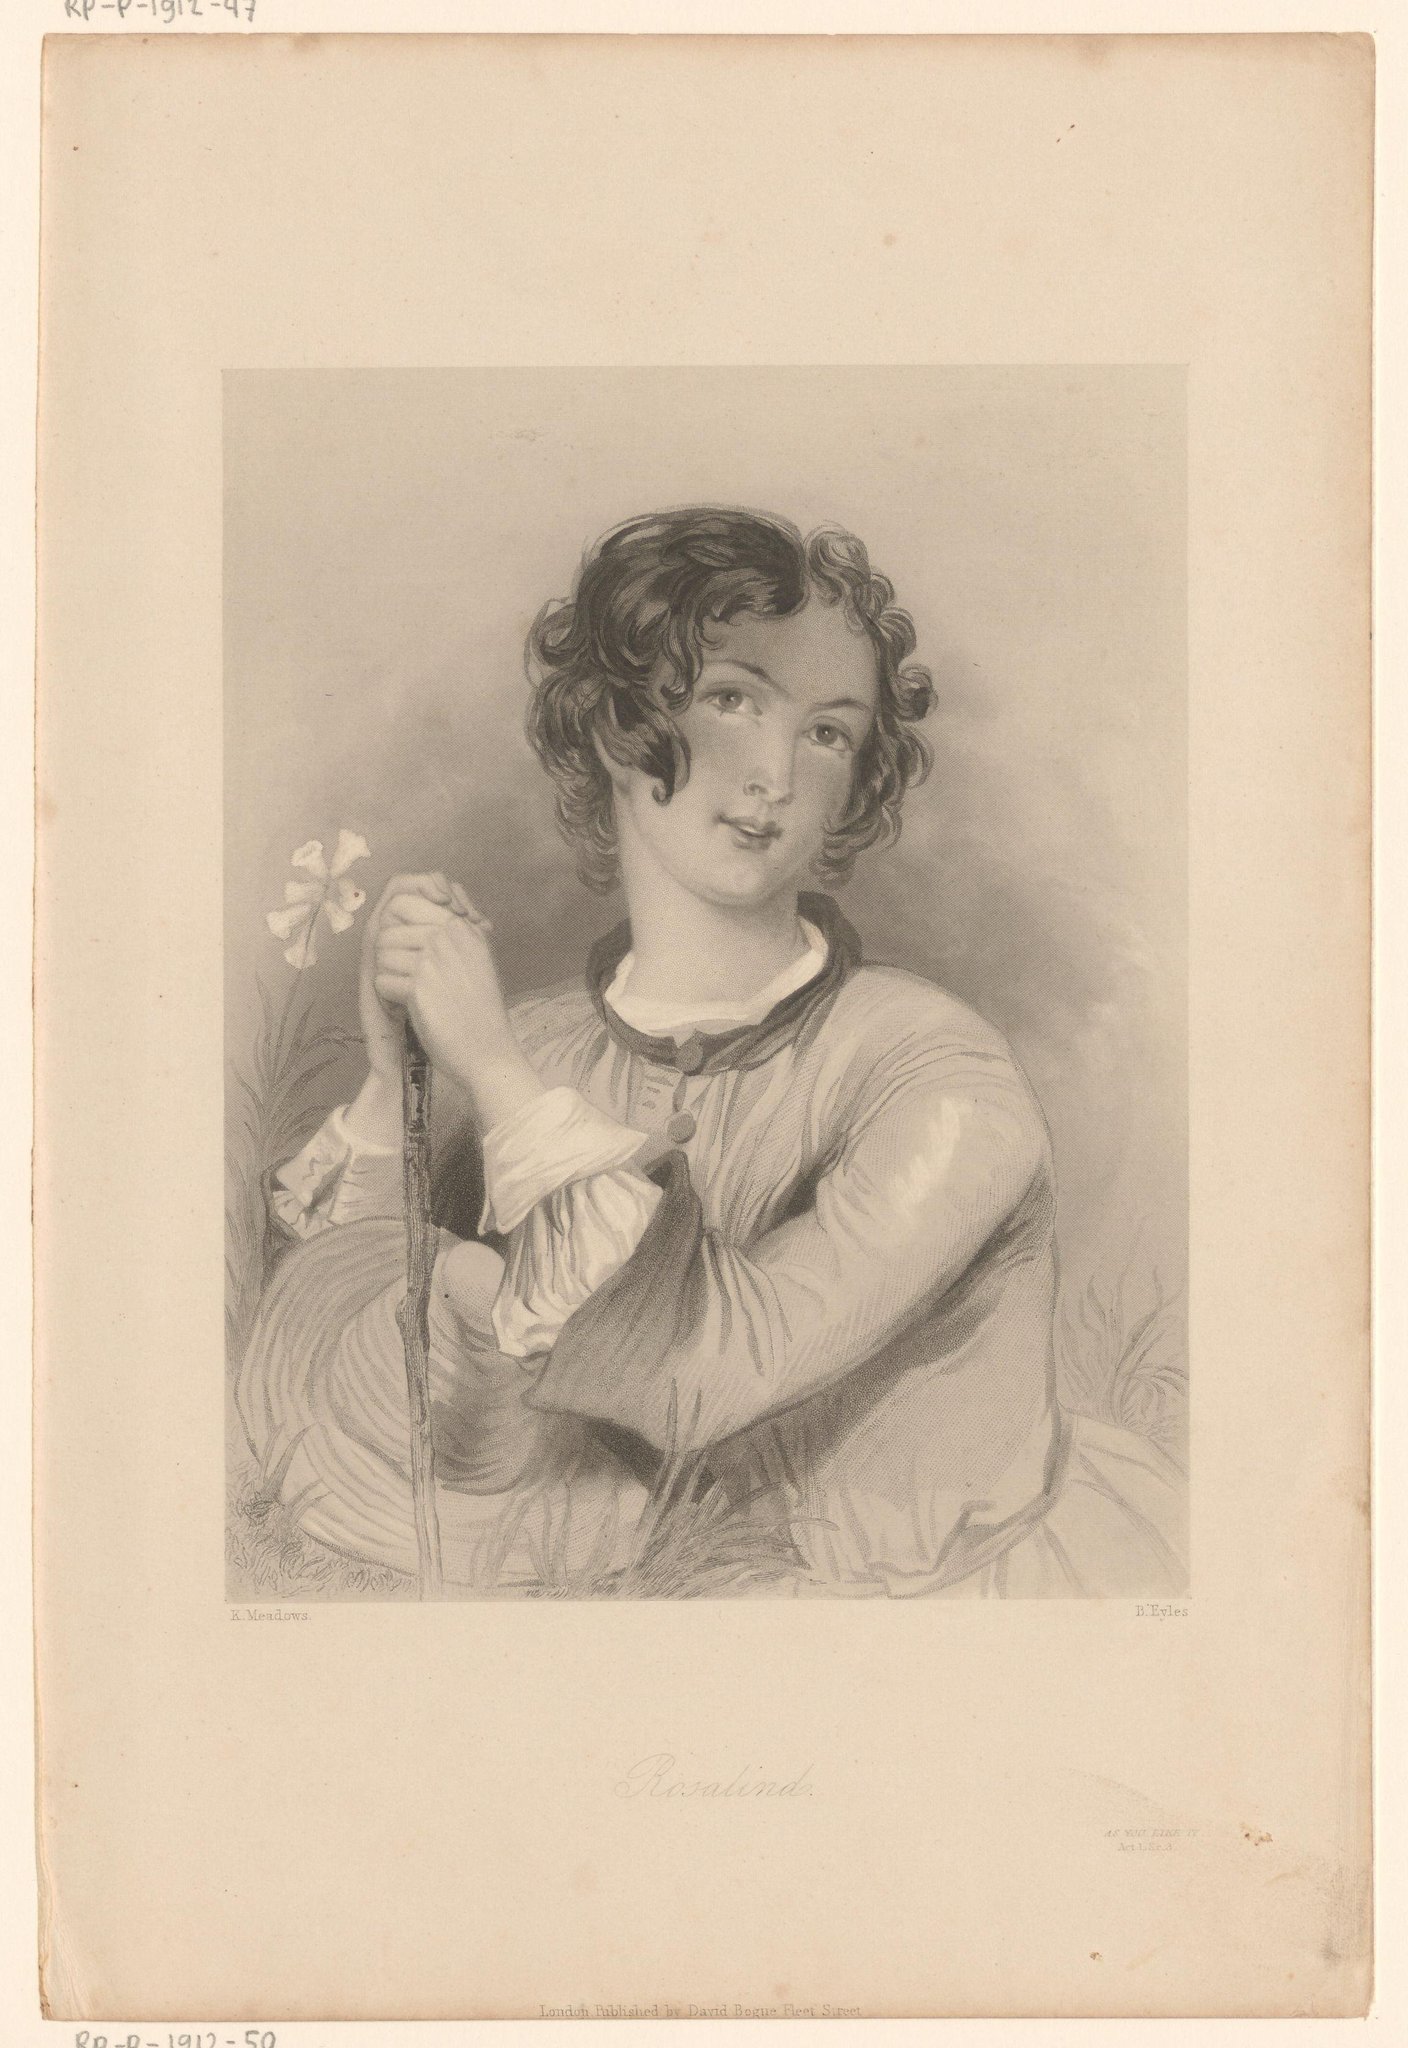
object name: book illustration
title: Rosalind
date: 1847-1848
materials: paper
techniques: etching, roulette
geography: london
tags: william shakespeare, female literary characters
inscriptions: collector's mark: Lugt 2228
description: Prent ook gebruikt in: Heath, Charles. The heroines of Shakespeare: comprising the principal female characters in the plays of the great poet. Londen: David Bogue, 1848.